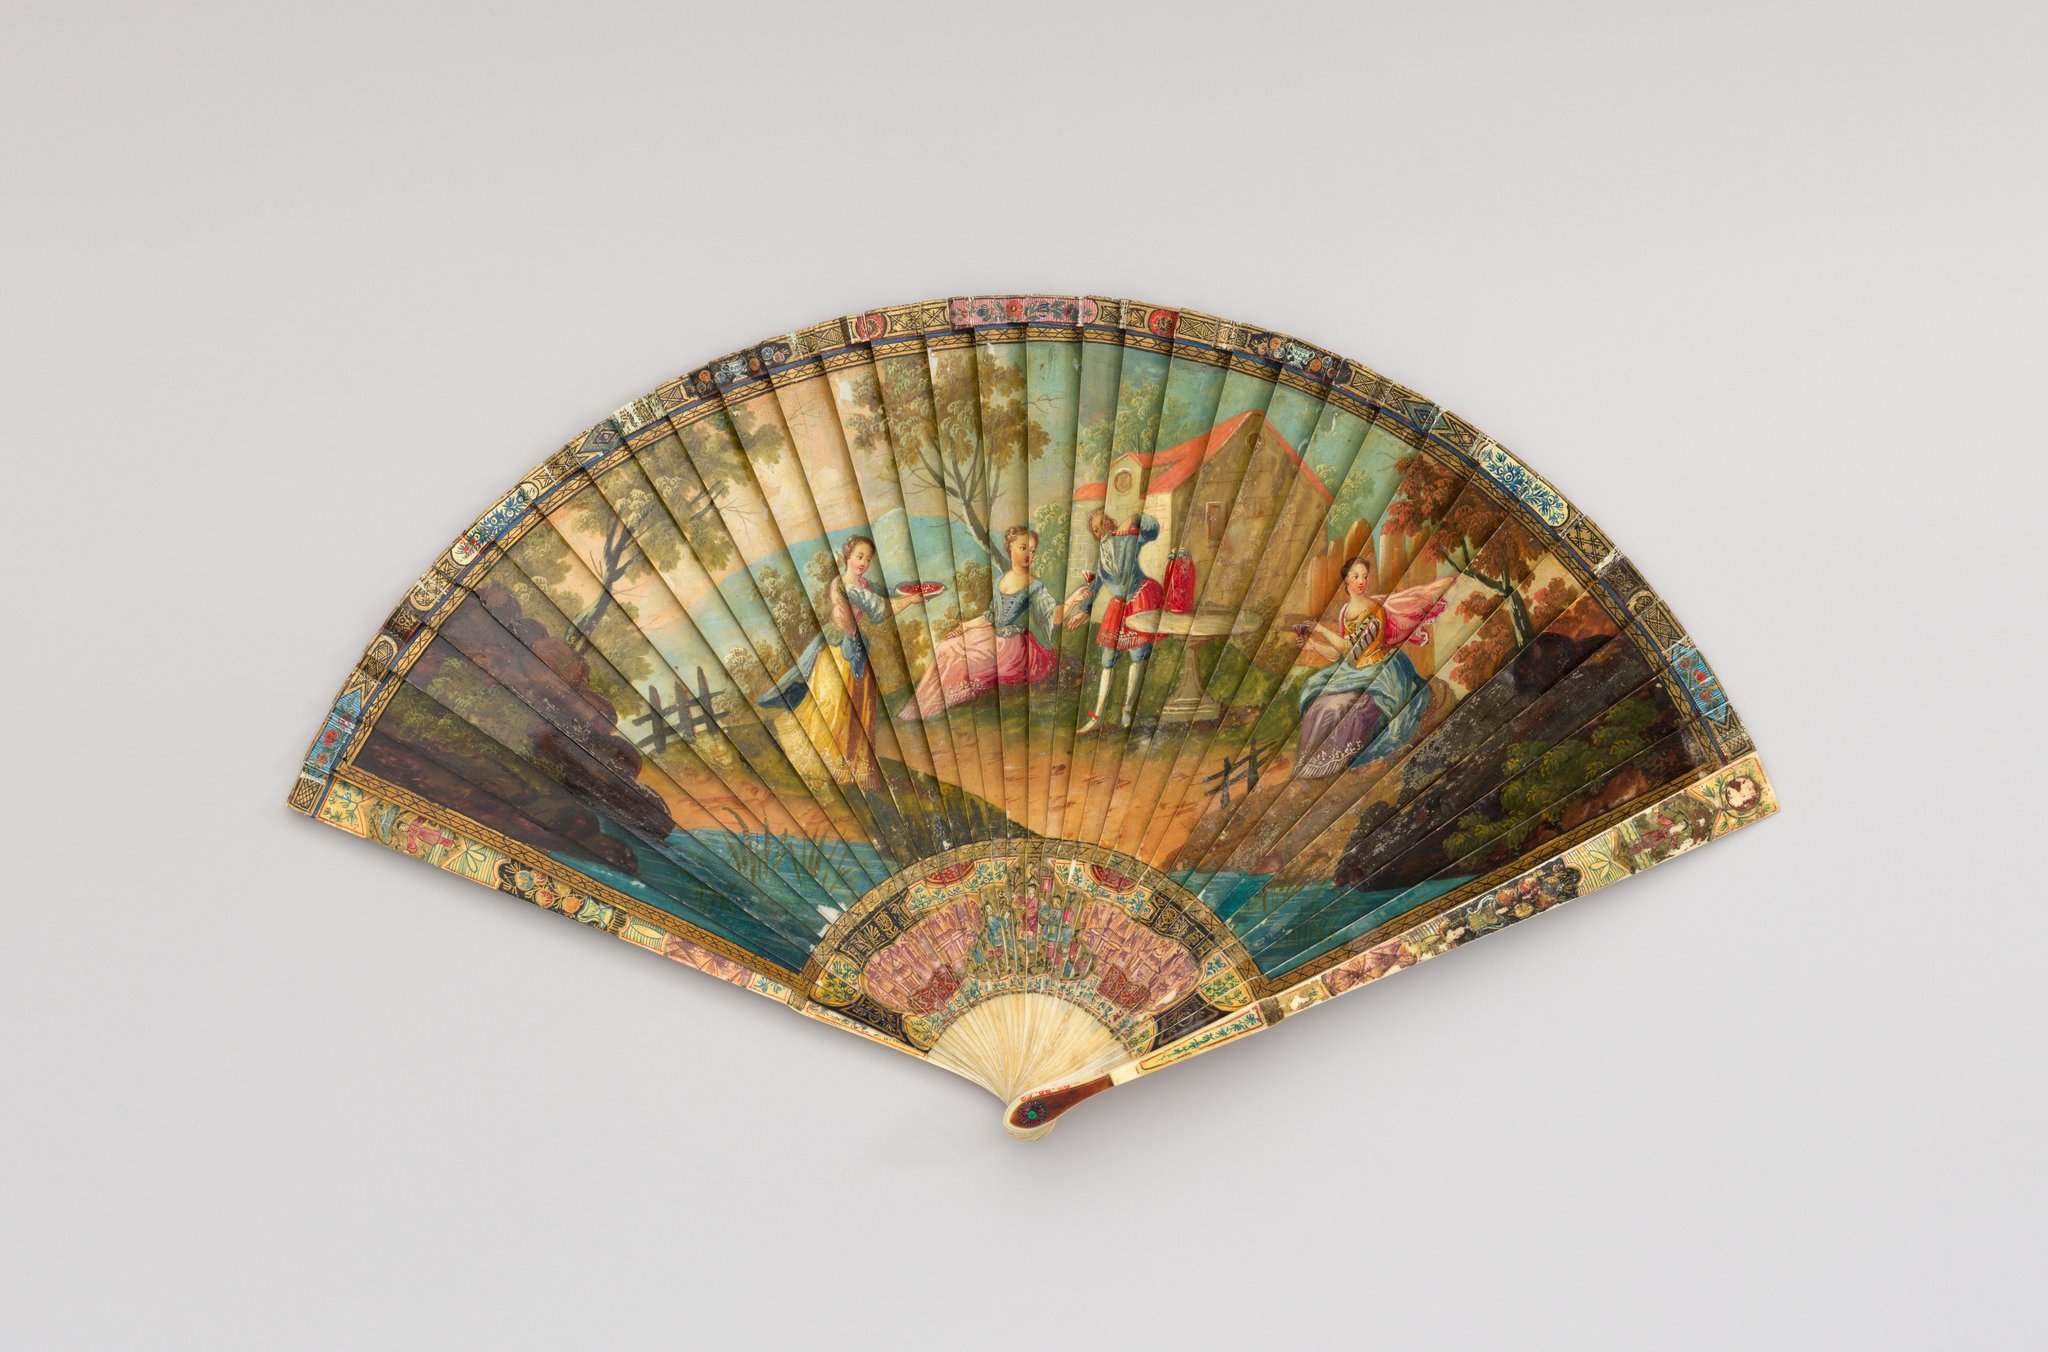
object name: fan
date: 1701-1800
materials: ivory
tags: men,women